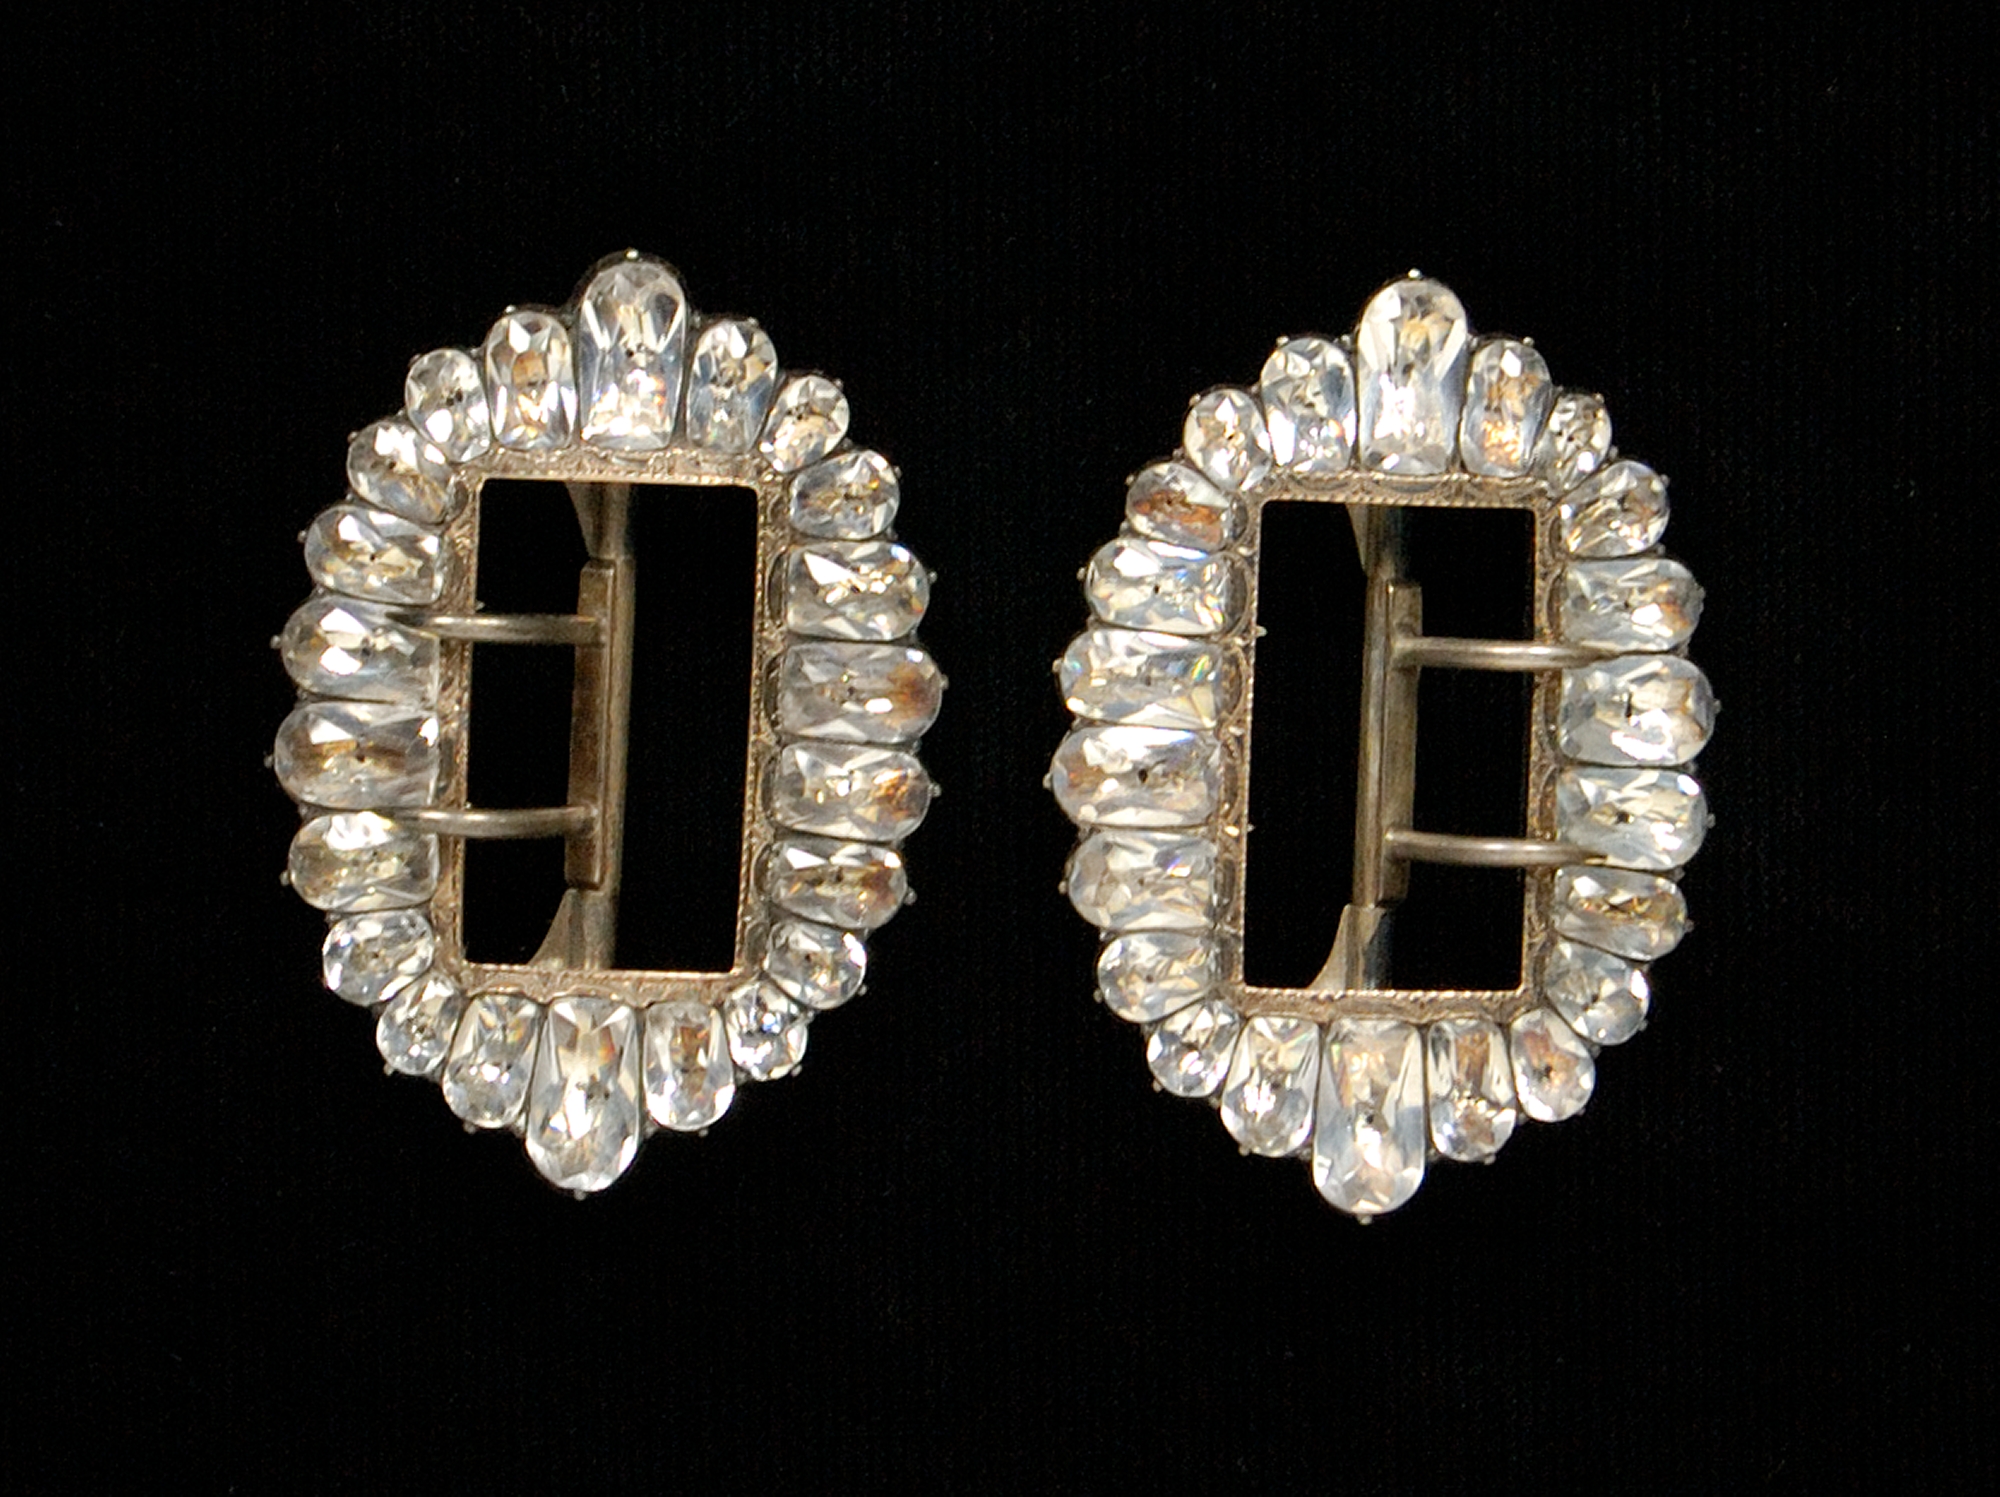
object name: shoe buckle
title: Shoe buckles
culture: french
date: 1780-1799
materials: glass, metal